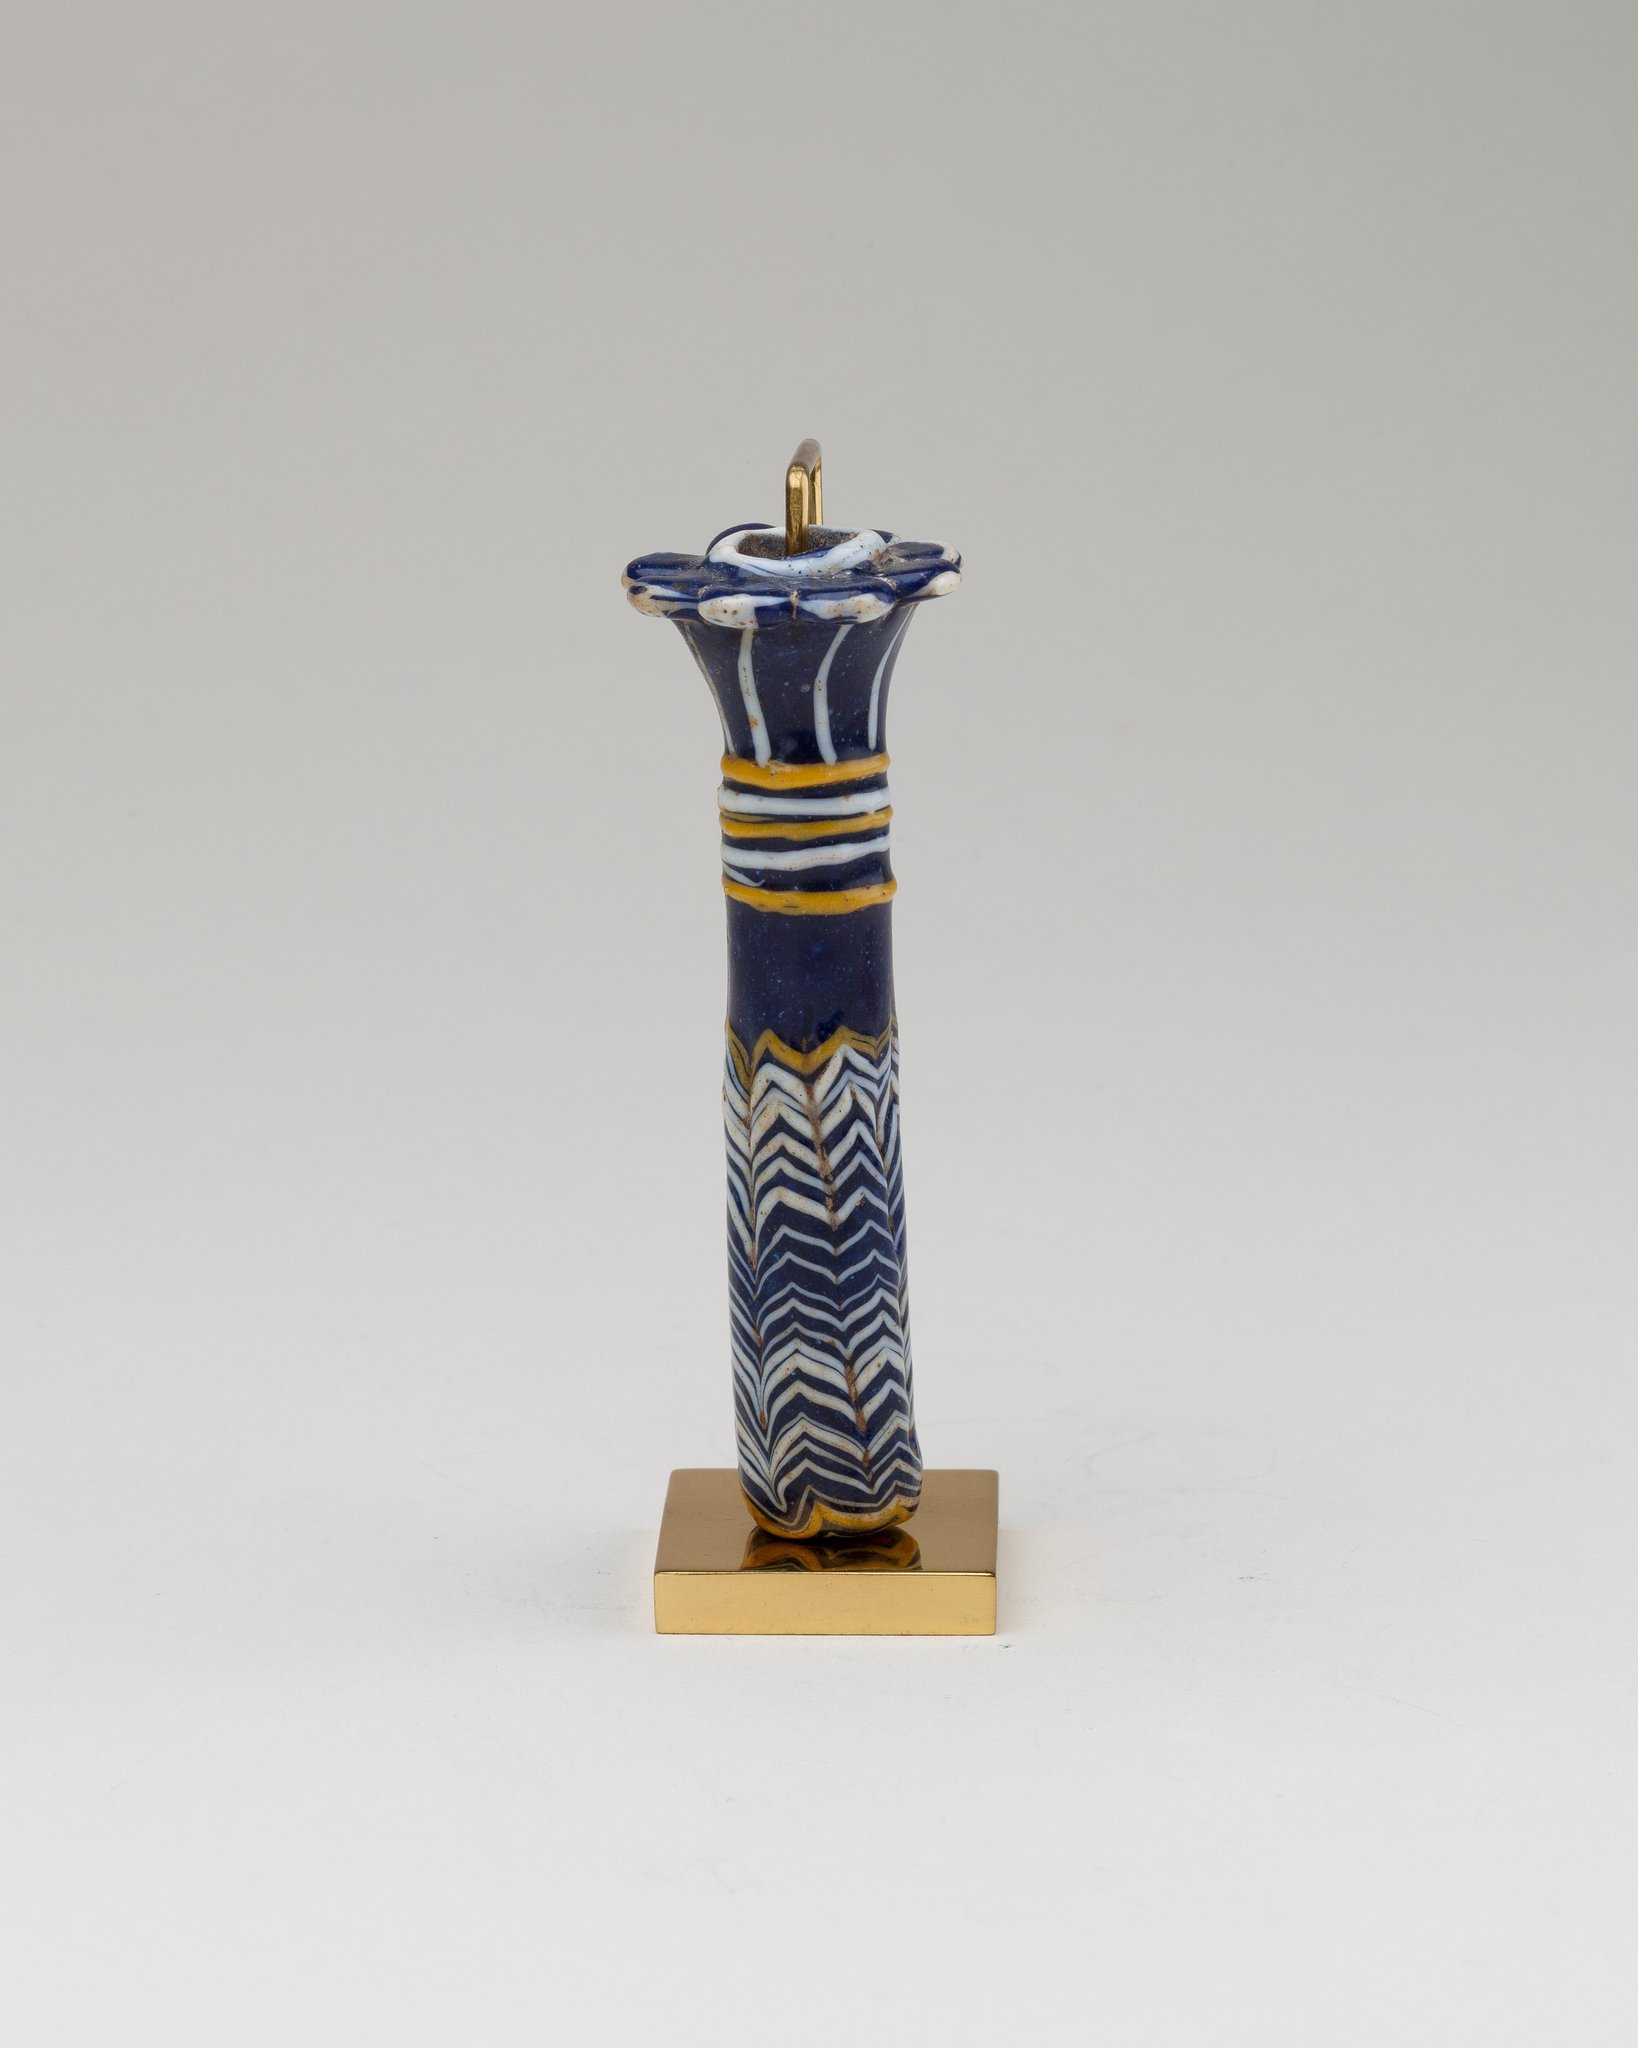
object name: kohl tube, papyrus column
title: Kohl Tube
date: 1295-1070 BCE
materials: glass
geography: egypt